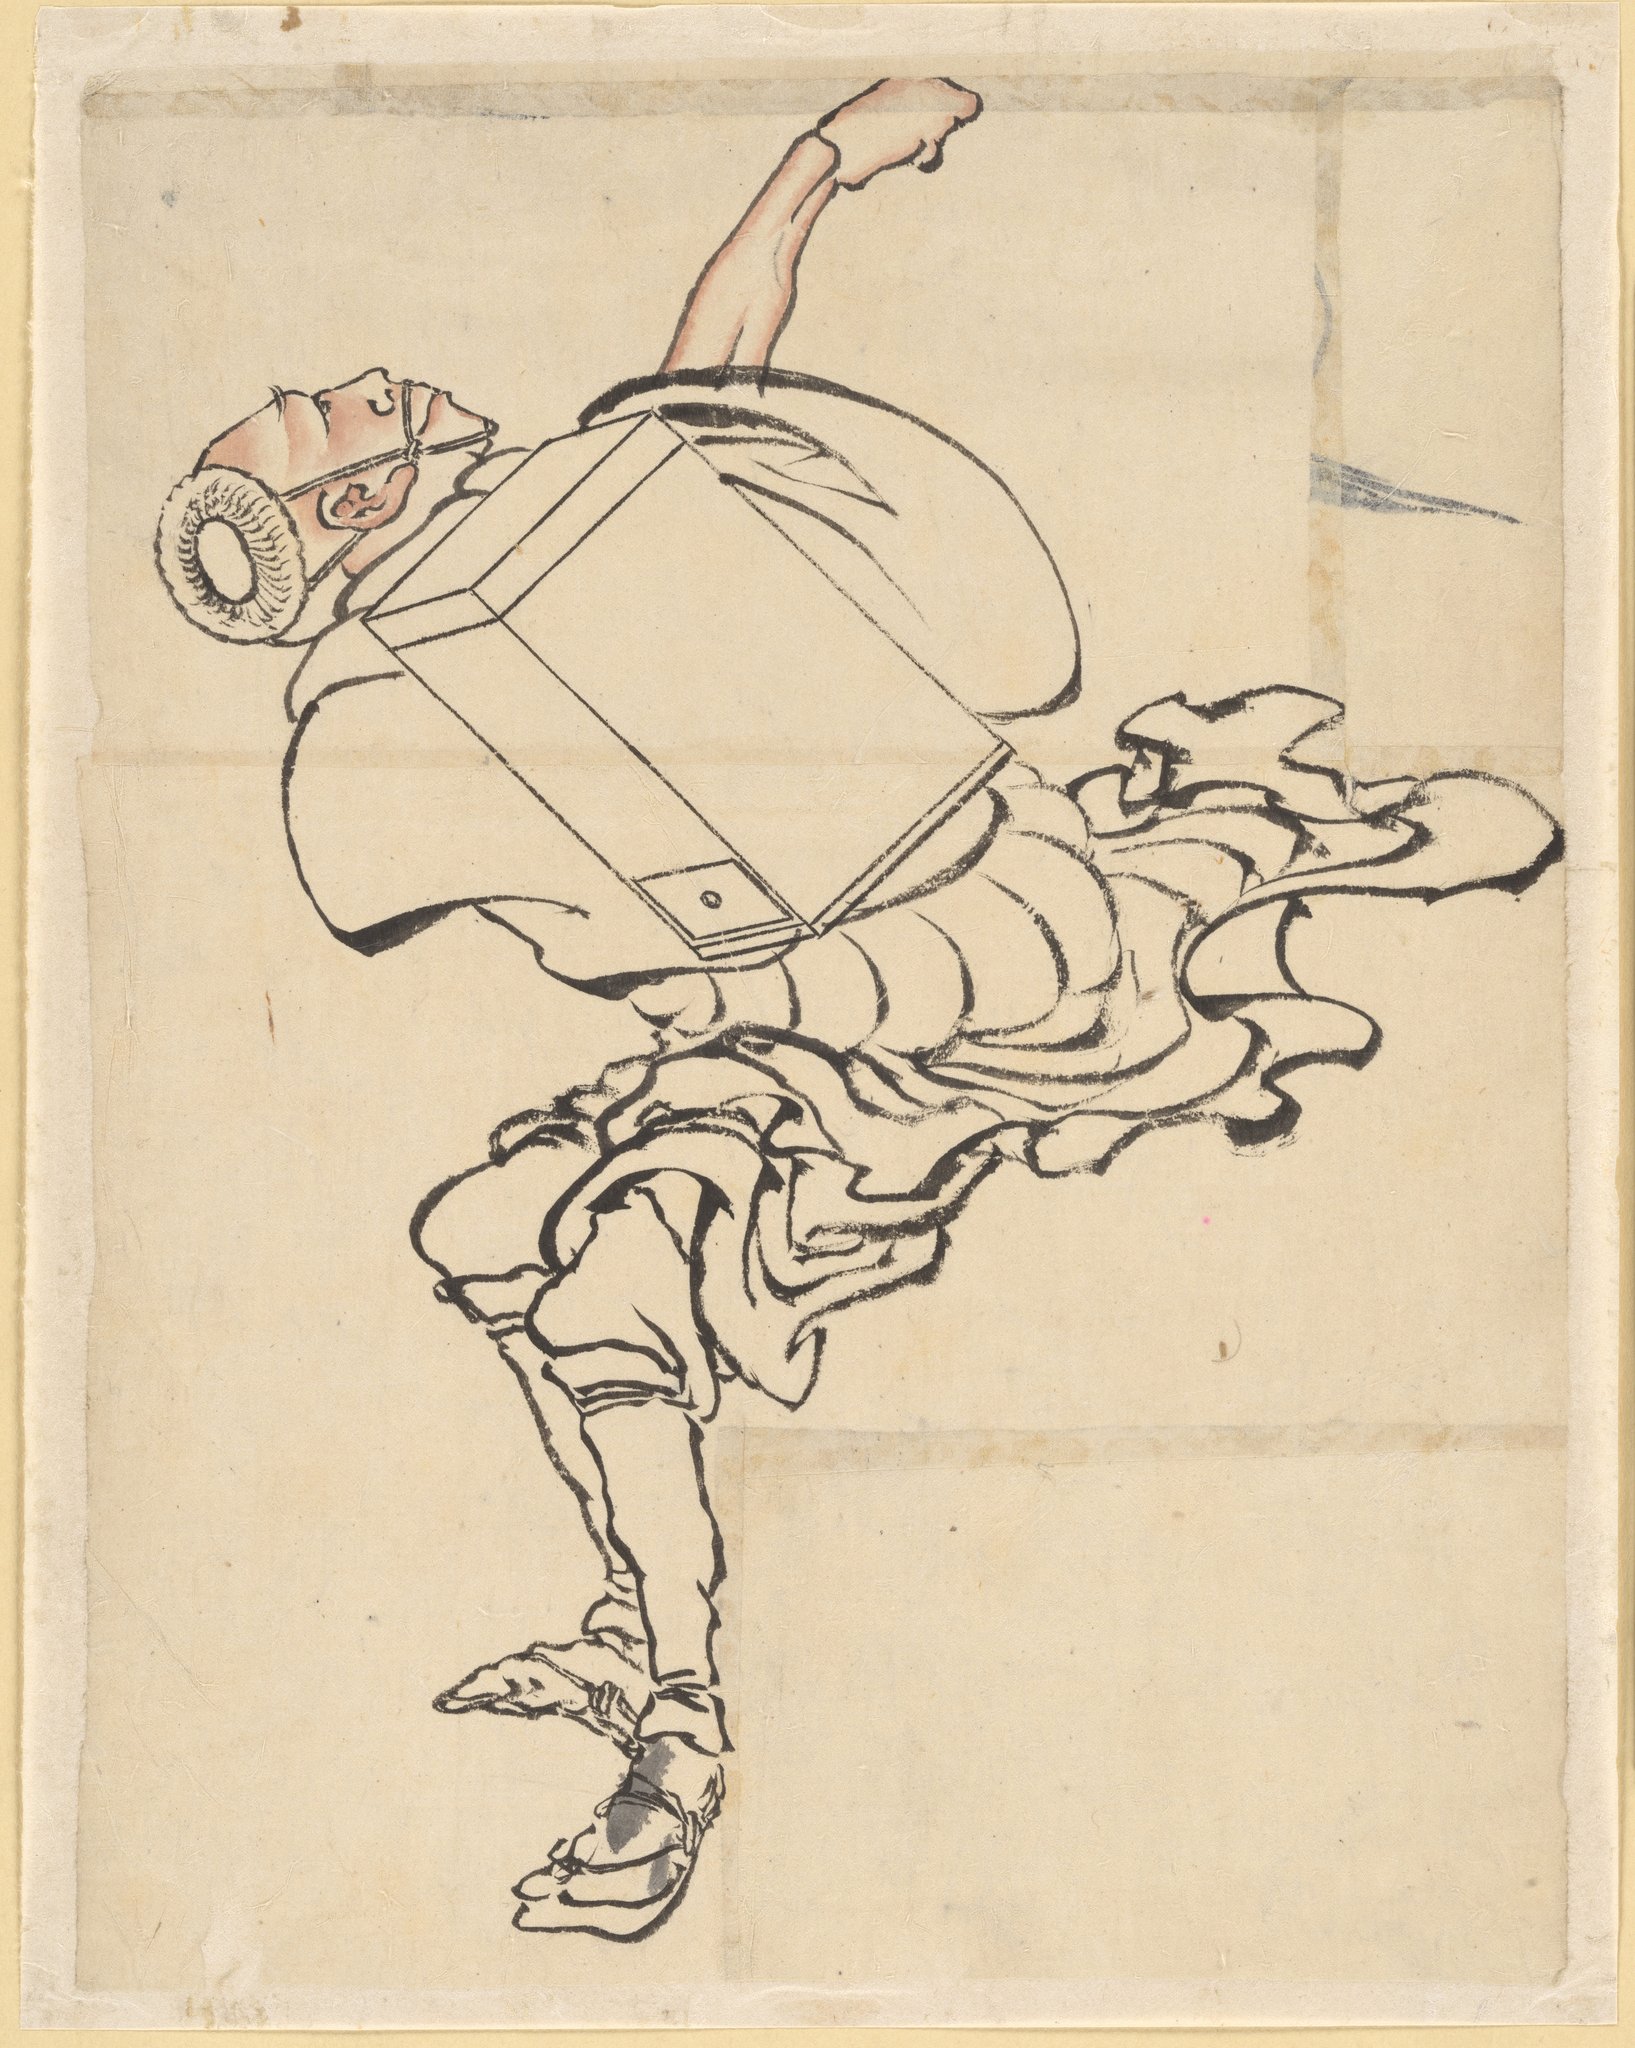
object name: drawing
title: Fan Peddler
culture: japanese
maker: katsushika hokusai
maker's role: artist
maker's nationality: japanese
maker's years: 1760-1849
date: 1701-1900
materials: ink, paper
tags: men,working